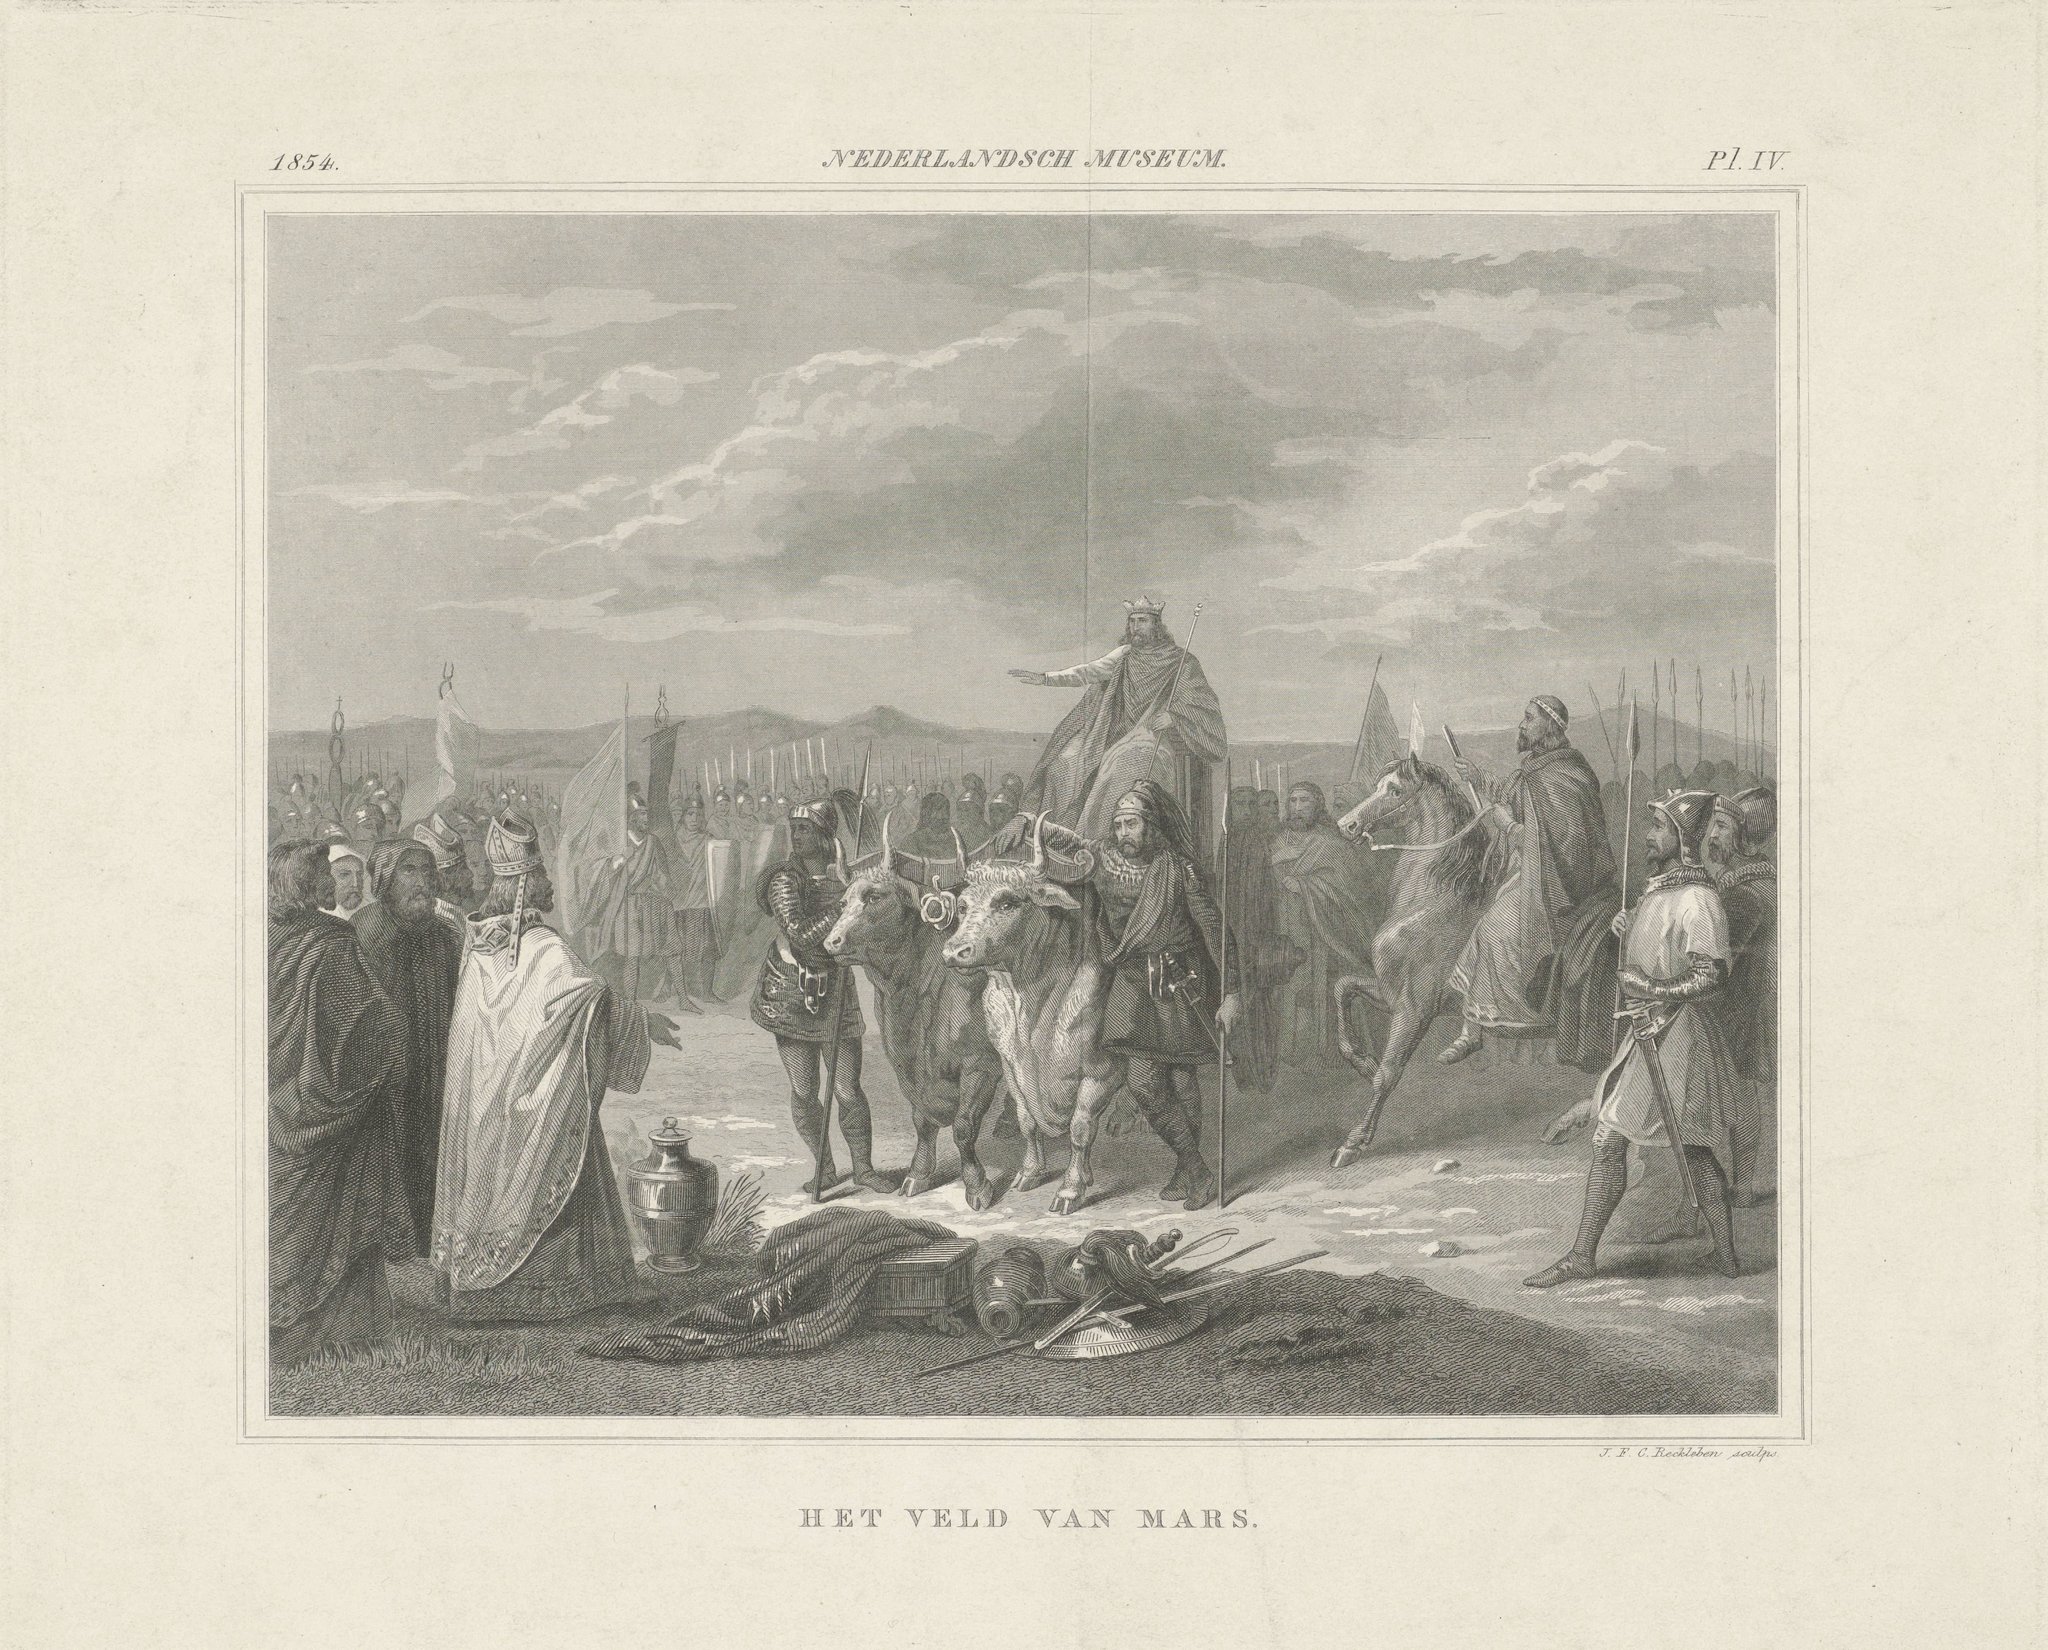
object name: print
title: Vergadering op een veld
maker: jan frederik christiaan reckleben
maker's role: print maker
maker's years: 1819-1879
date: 1854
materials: paper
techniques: engraving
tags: ruler, sovereign - bb - female ruler, organization, functionaries and dignitaries in churches and in related institutions, political meeting, propaganda meeting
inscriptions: collector's mark: Lugt 2228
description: Op een veld houdt een koning, gezeten op een troon die door twee ossen getrokken wordt, halt bij een groep geestelijken. De koning converseert met de voorman van de geestelijken. Het leger van de koning heeft zich achter hem geschaard.